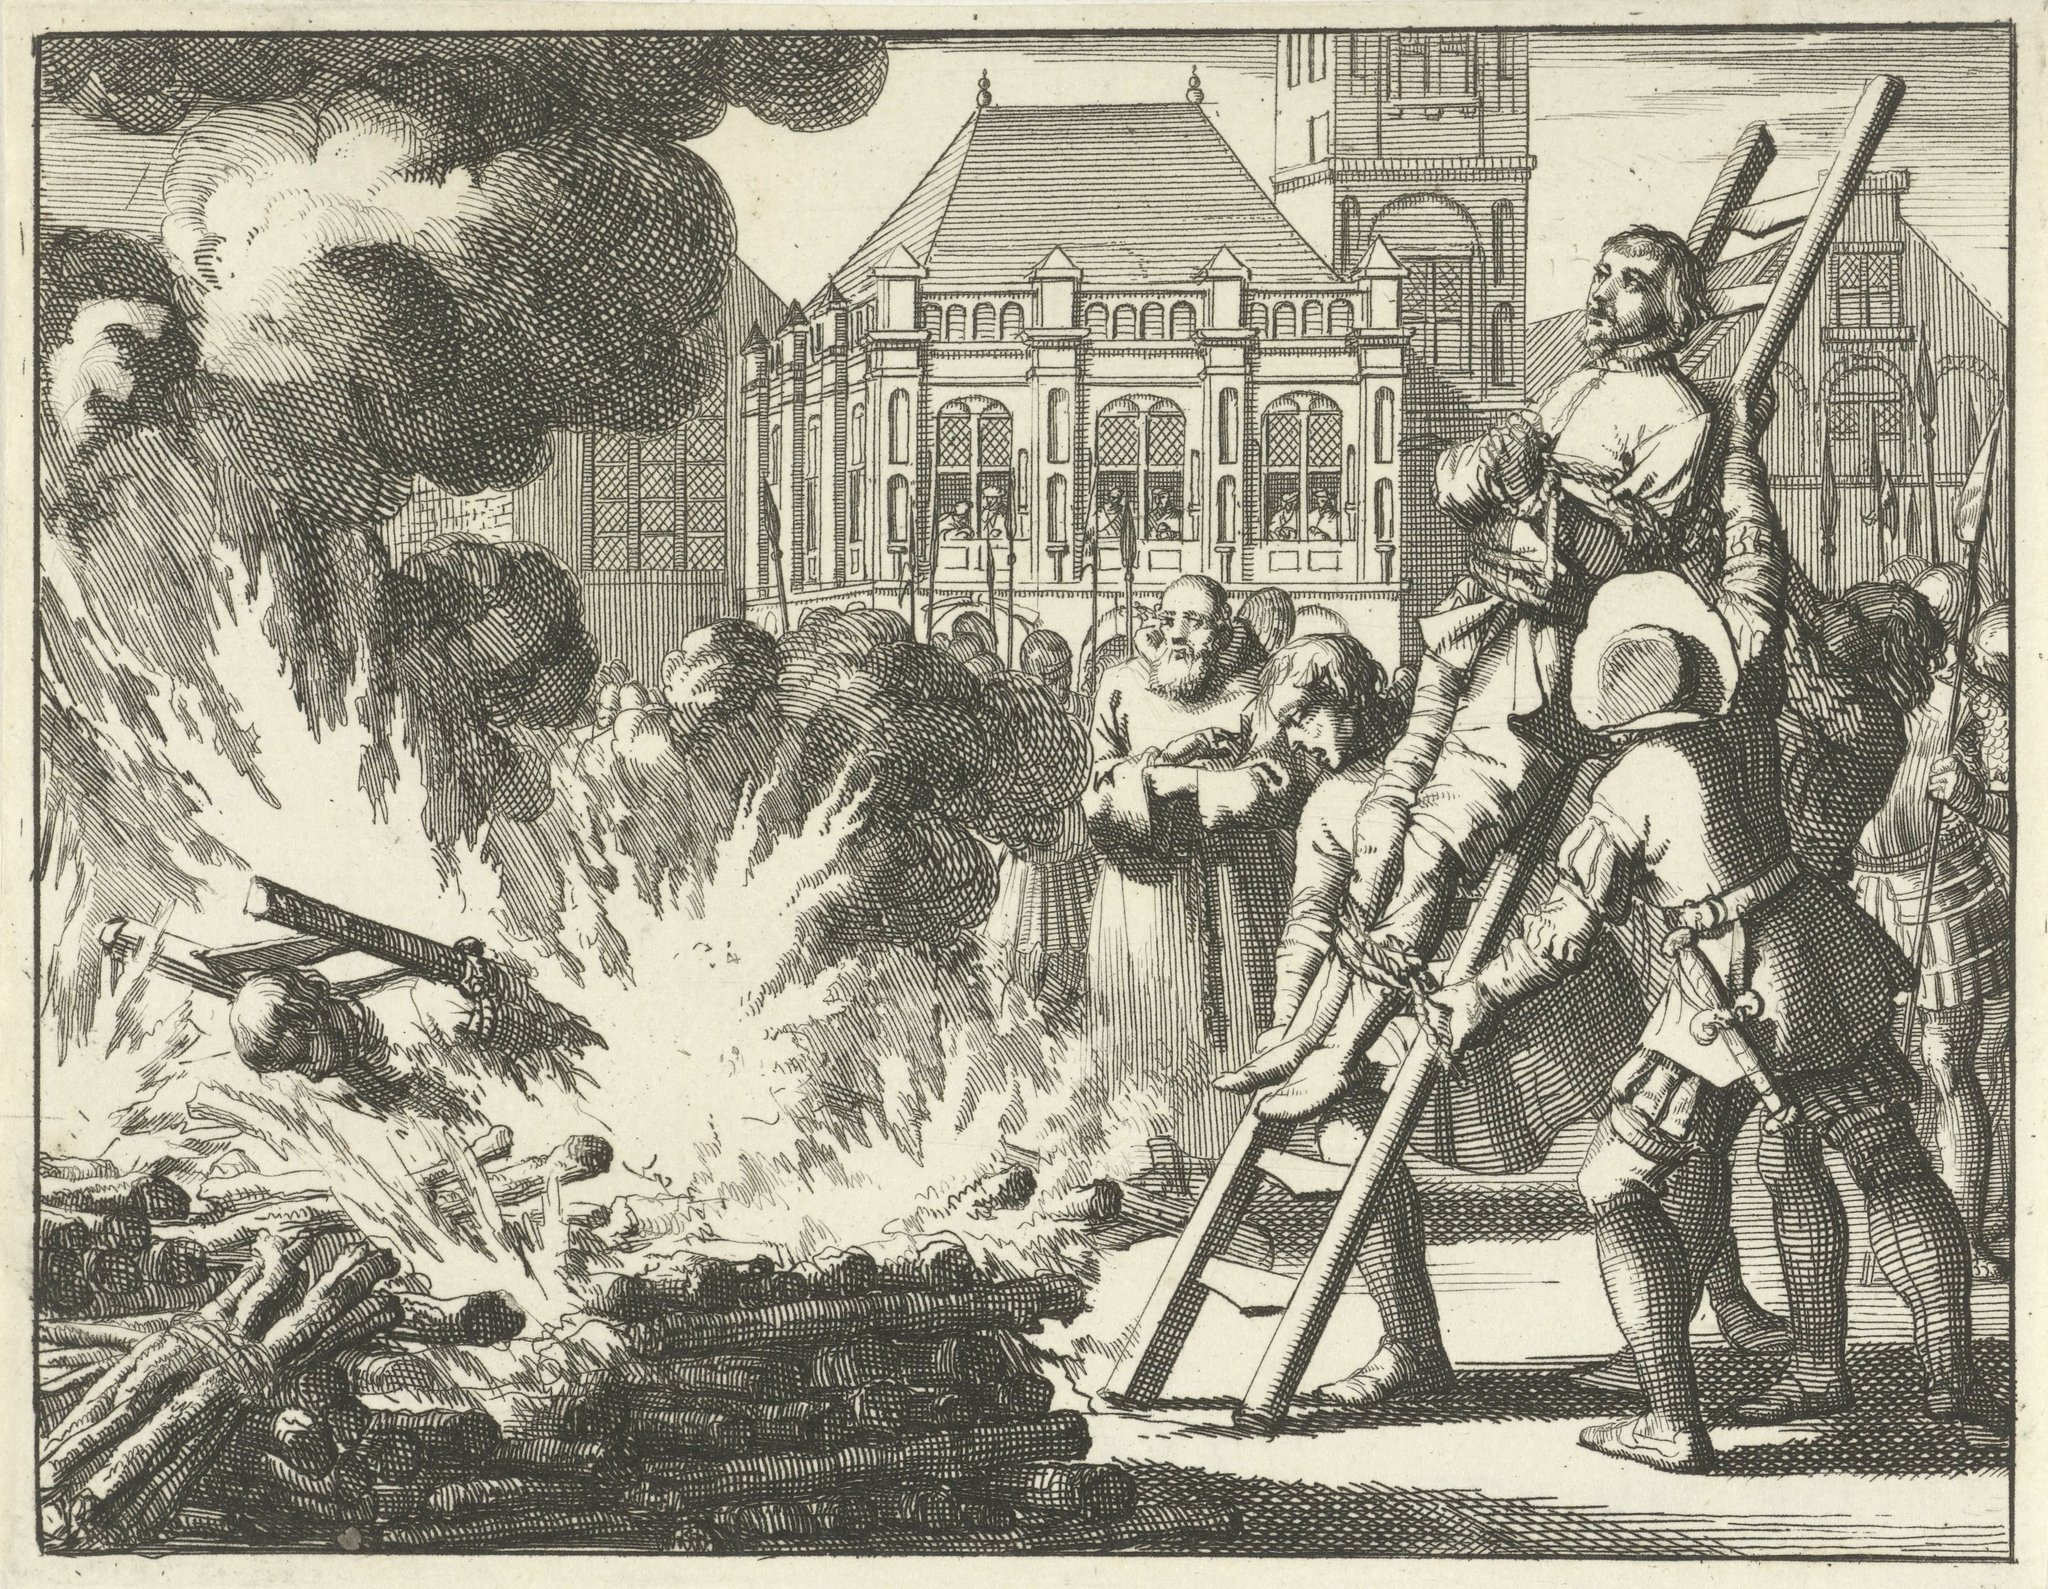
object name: book illustration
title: Jacob de Geldersman en Dirk Pietersz. Smuel op de Dam op de brandstapel, 1546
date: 1693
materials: paper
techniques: etching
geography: amsterdam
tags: execution of heretic, e.g. by burning at the stake, 'auto-da-fé', violent death by burning at the stake; pyre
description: Illustratie uit: Commelin, Caspar. Beschryvinge van Amsterdam, 2 delen. Amsterdam: Abraham Wolfgang, Gillis Janssonius van Waesberge, Johannes Janssonius van Waesberge II, weduwe Dirk Boom I, Hendrick Boom, Rembertus Goethals, 1693, dl. II, p. 944.